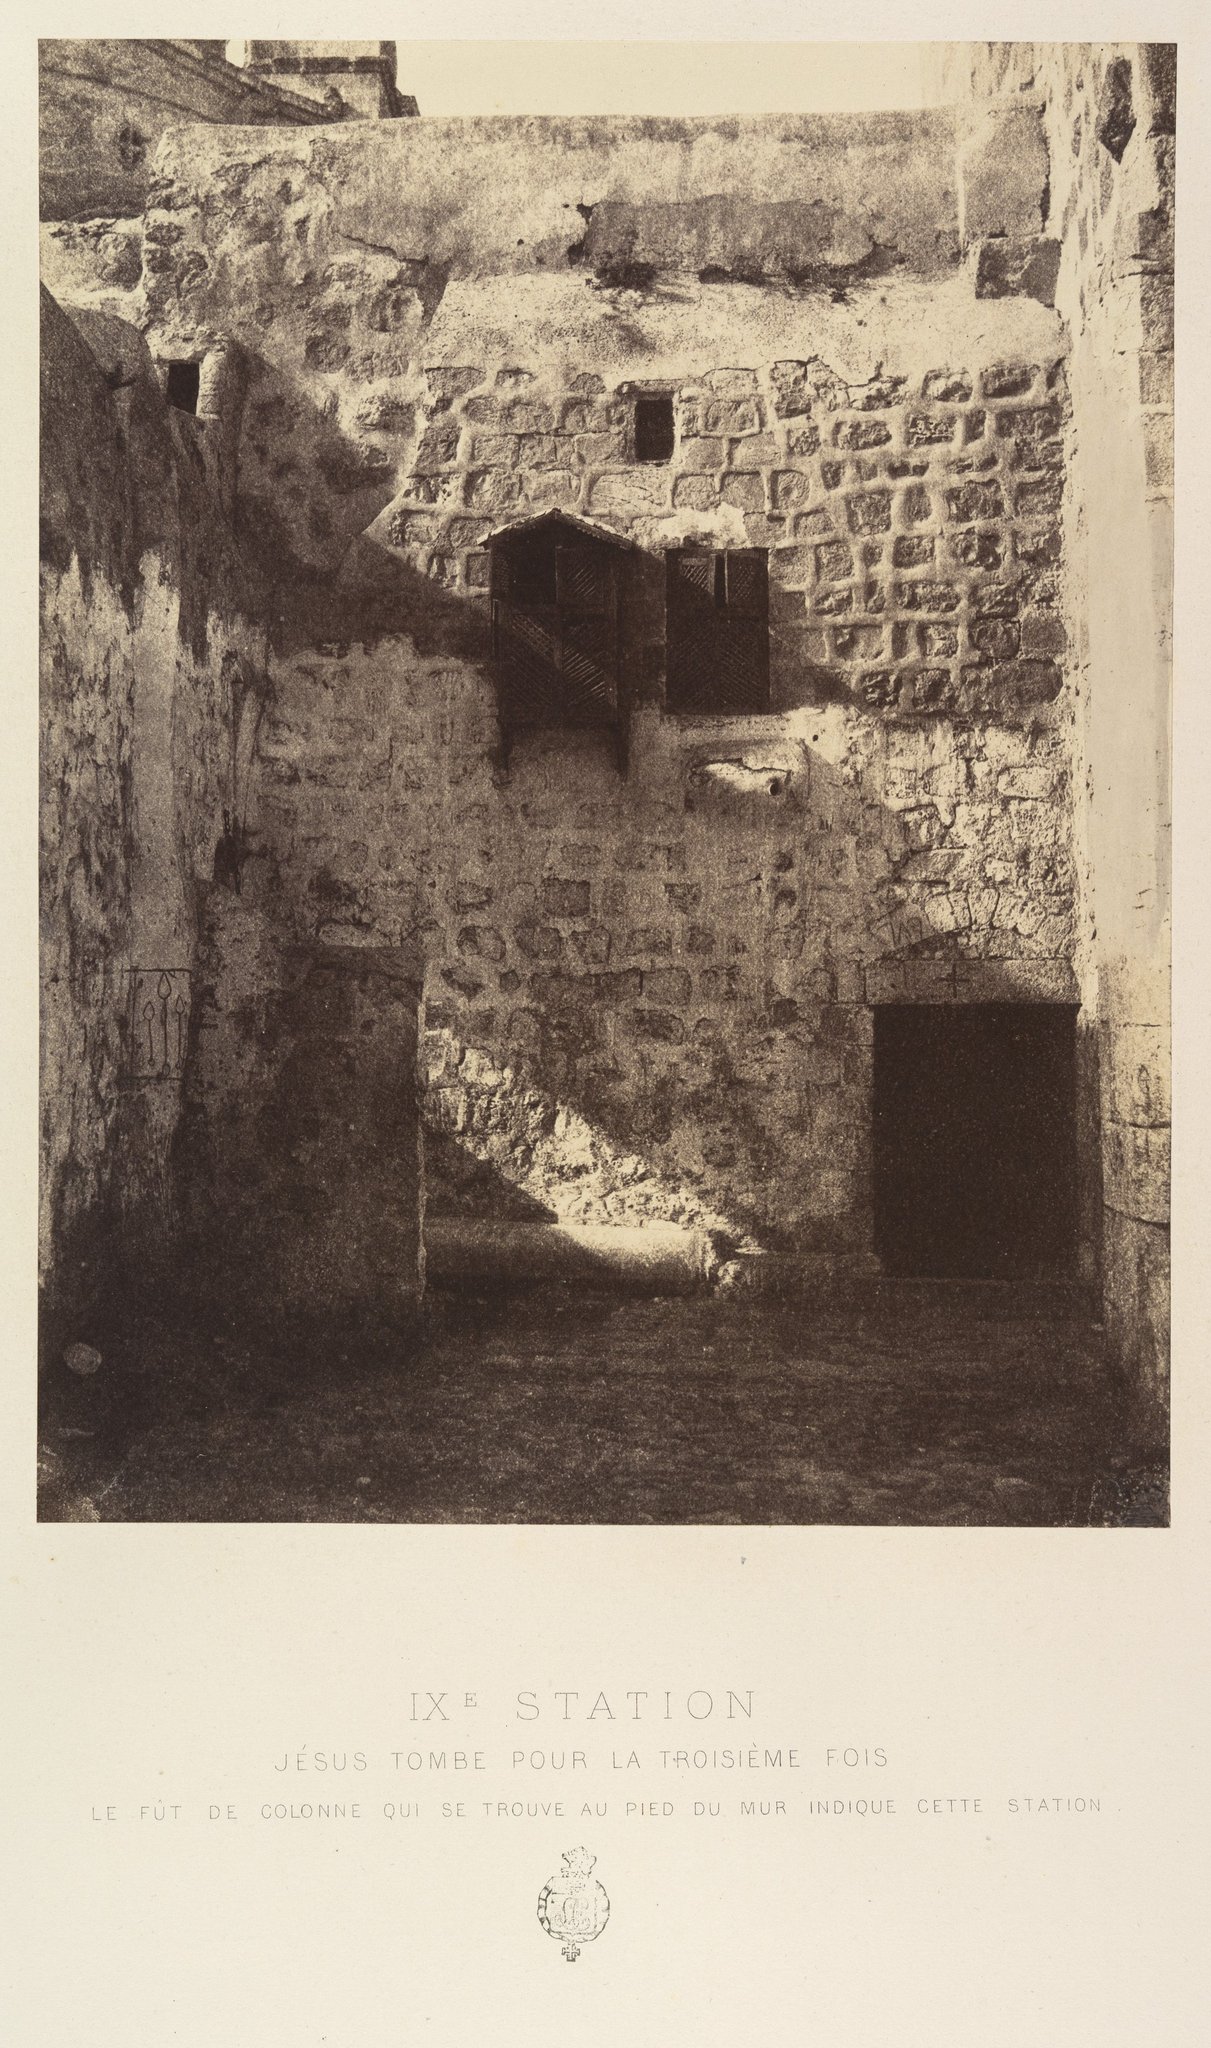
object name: photograph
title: IXe Station. Jésus tombe pour la troisième fois. Le fut de colonne qui se trouve au pied du mur indique cette station.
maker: louis de clercq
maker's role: artist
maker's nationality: french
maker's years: 1837-1901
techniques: albumen silver print, paper negative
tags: architecture,buildings